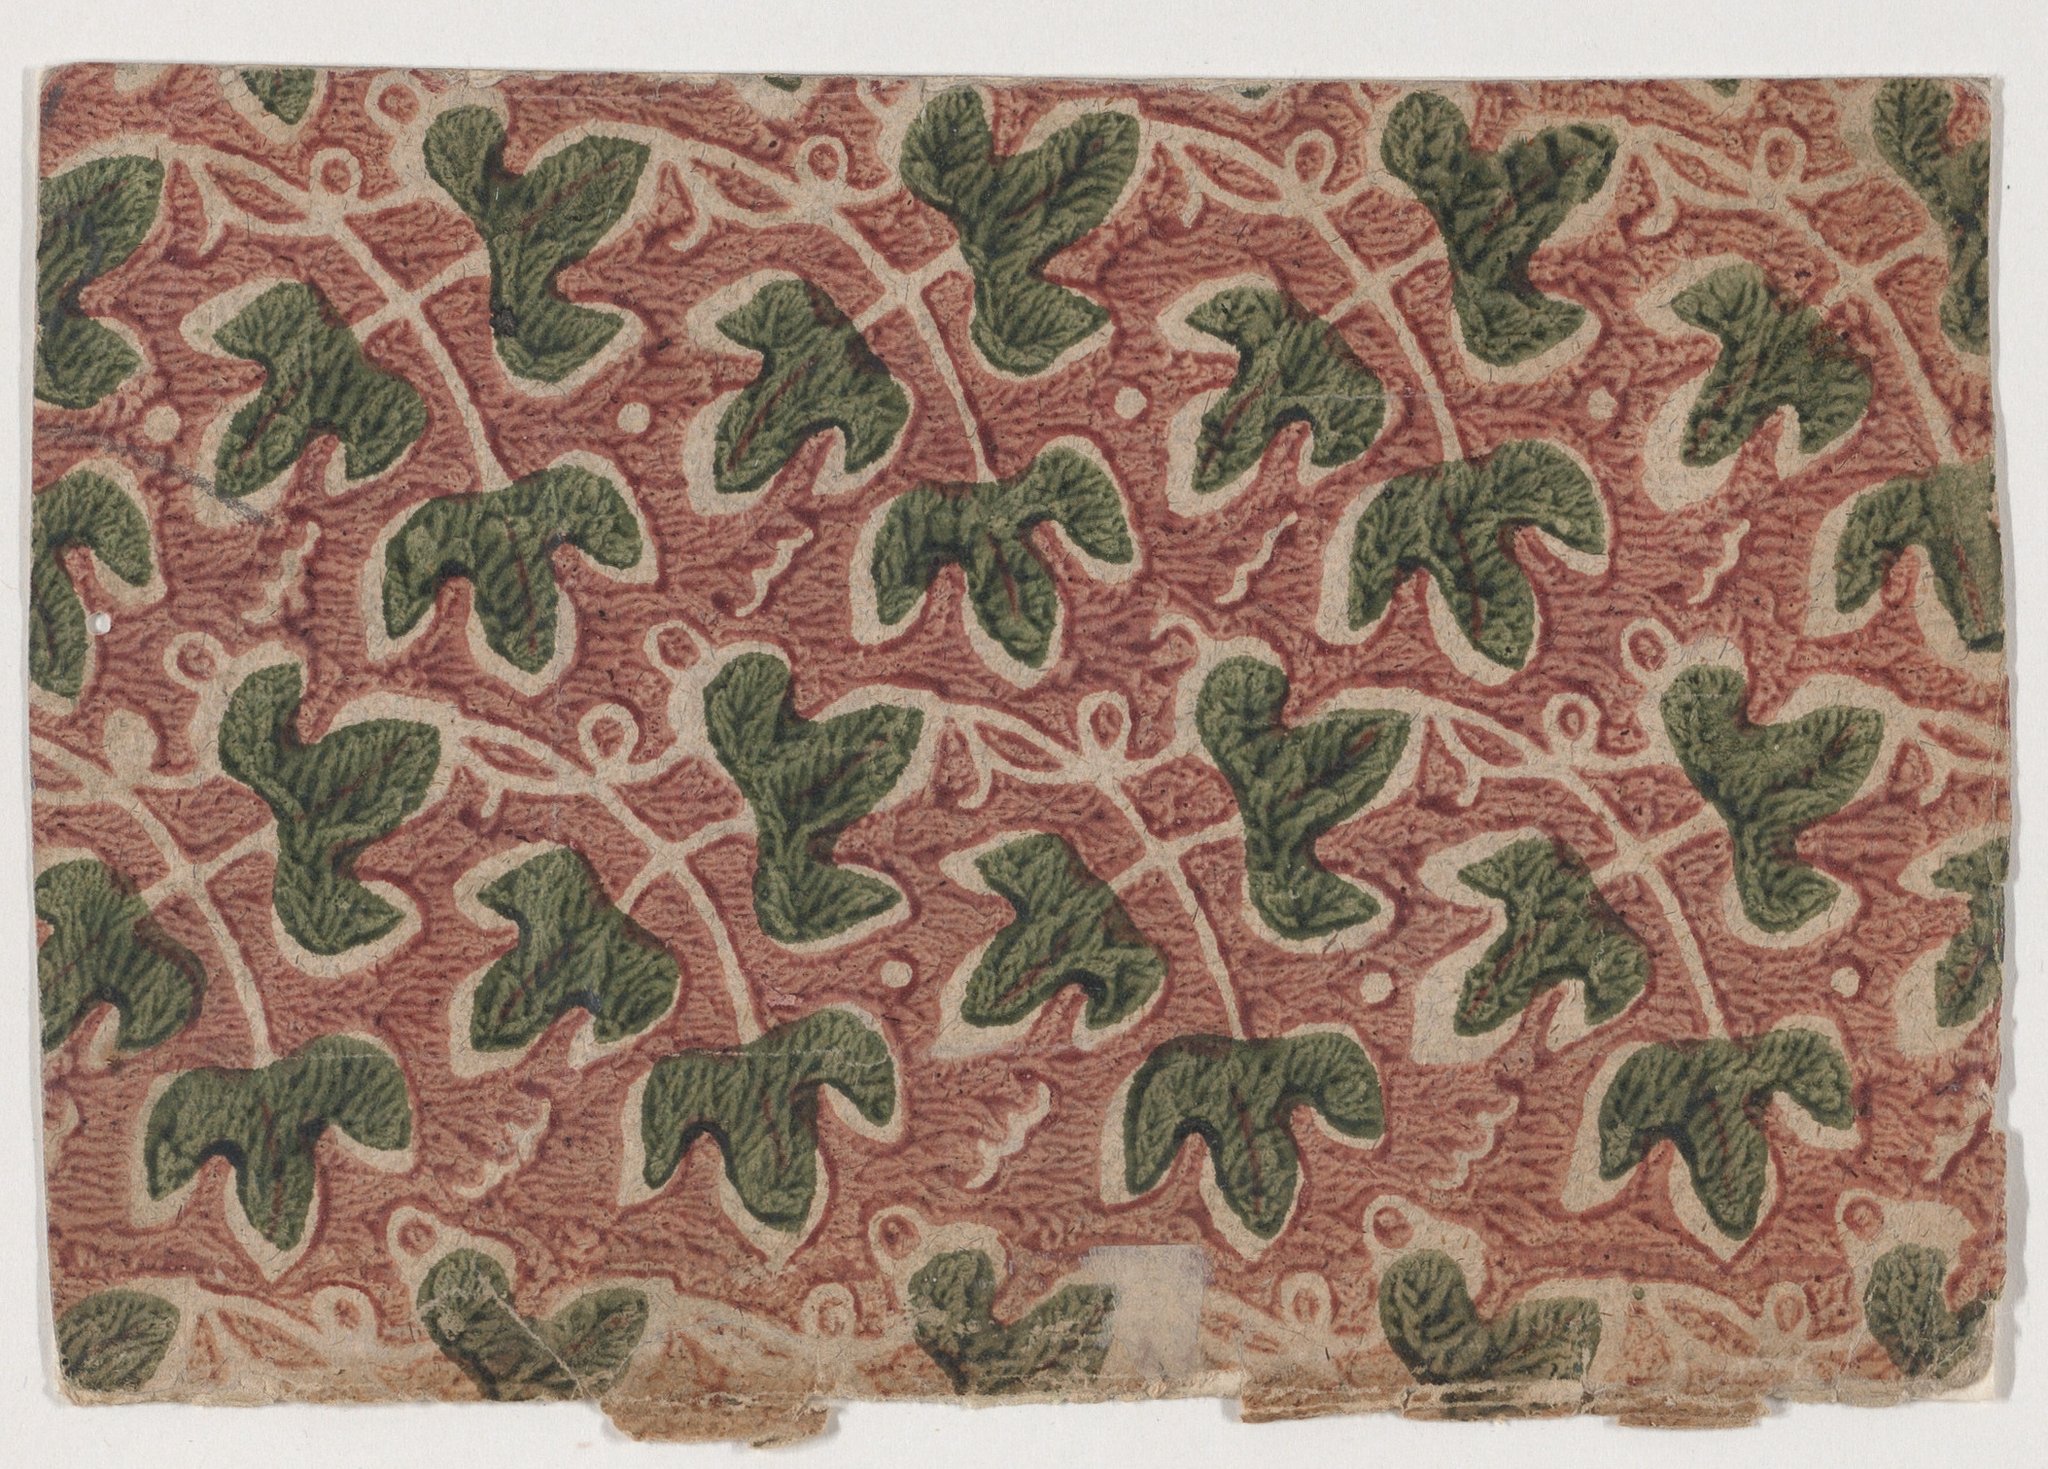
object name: print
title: Sheet with overall leaf pattern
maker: Anonymous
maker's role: artist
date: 1801-1900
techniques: relief print